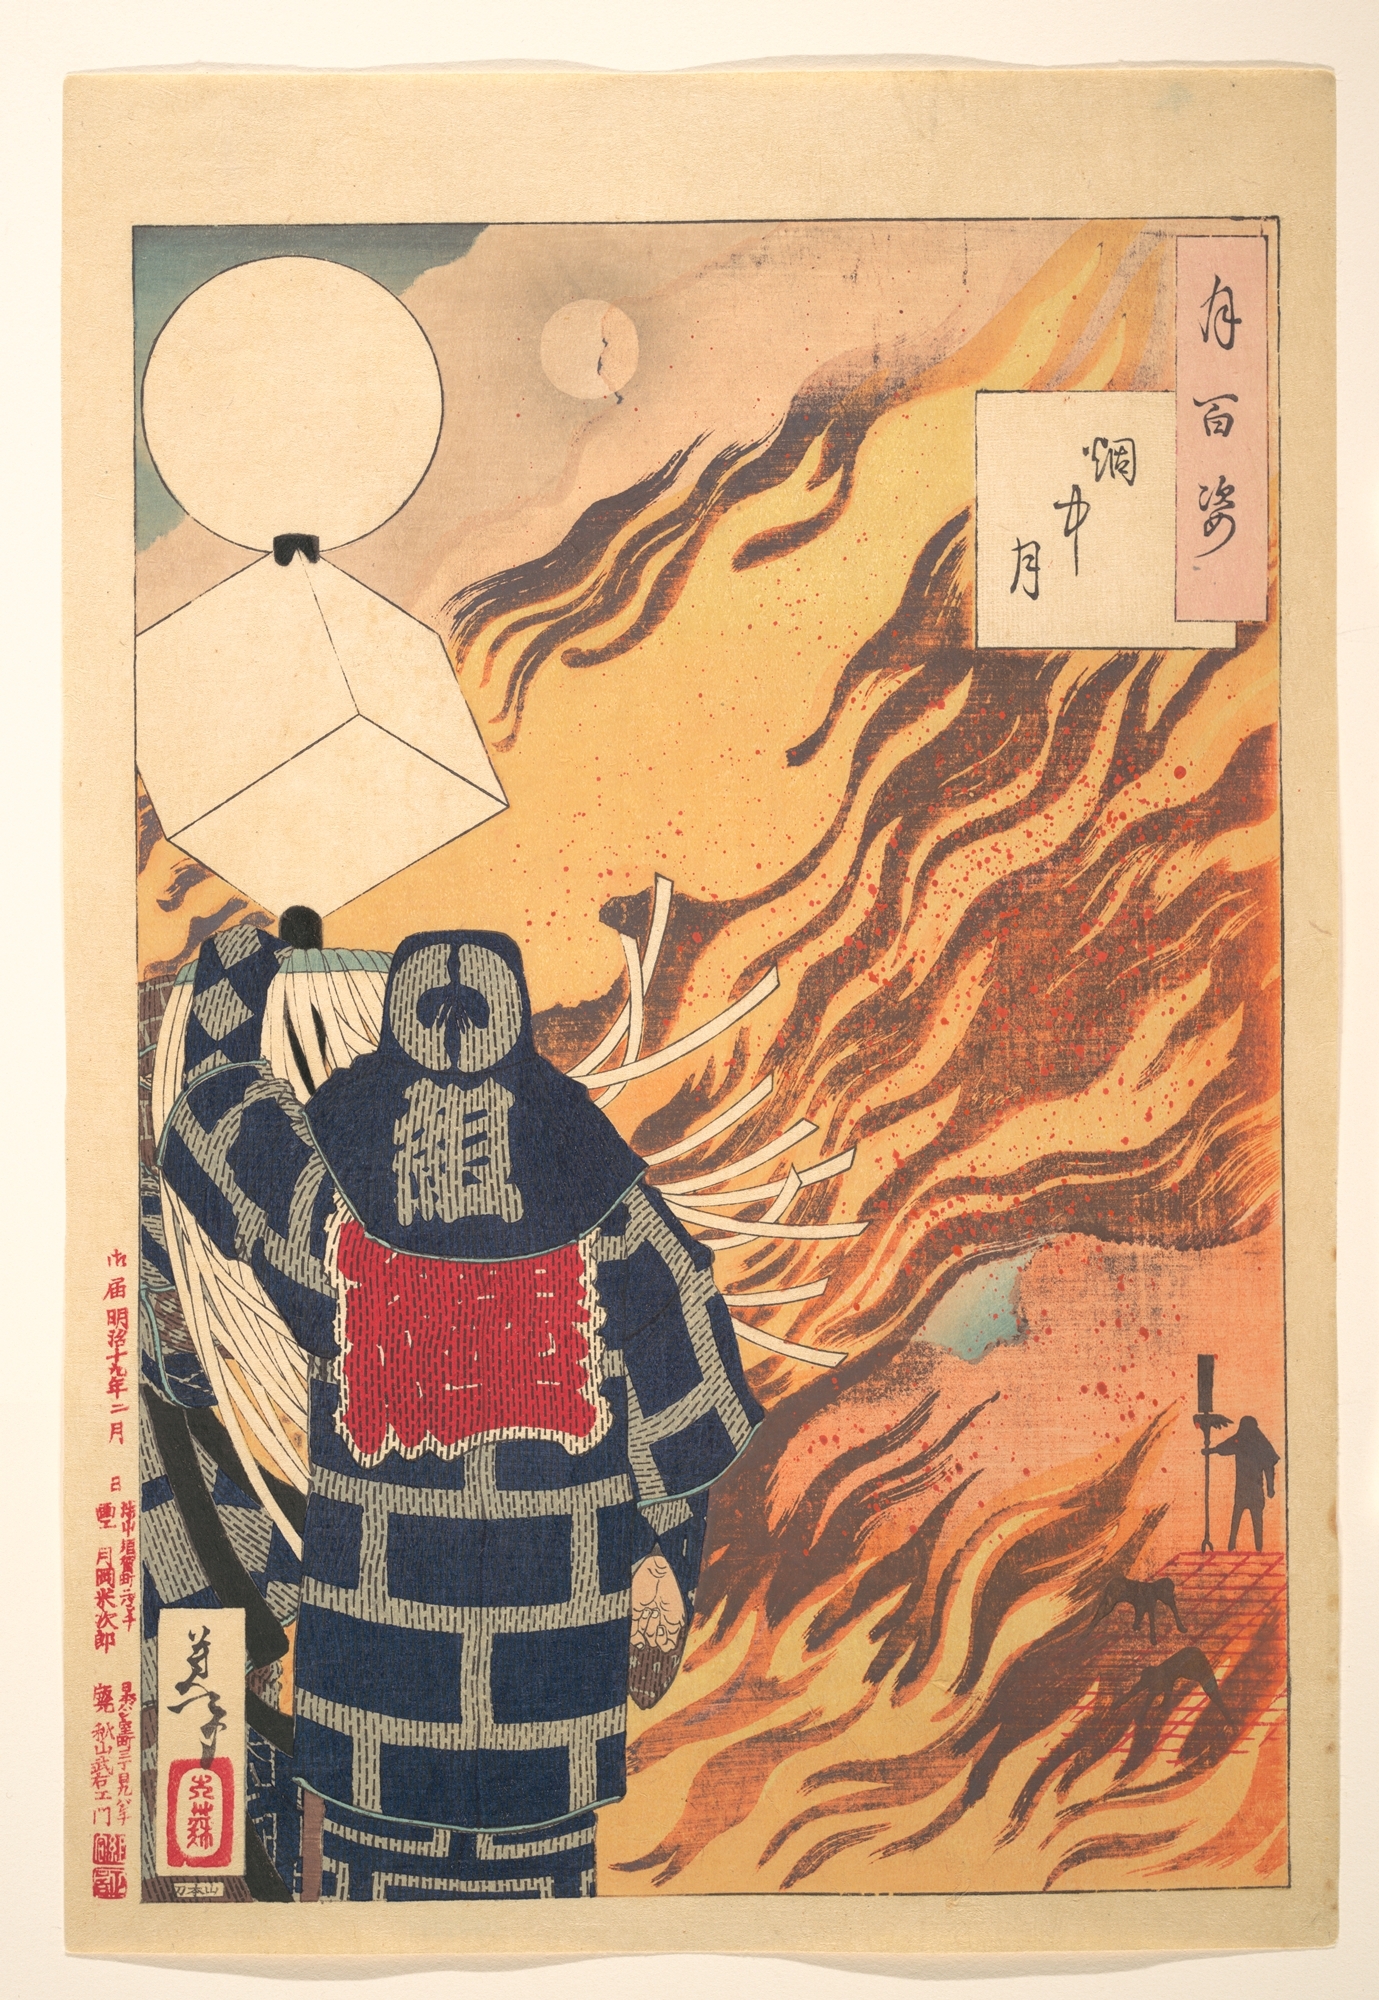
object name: print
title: Moon in the Flame from the Series One Hundred Images of the Moon (Tsuki hyaku sugata-enchūgetsu)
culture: japanese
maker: tsukioka yoshitoshi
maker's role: artist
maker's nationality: japanese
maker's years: 1839-1892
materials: ink, paper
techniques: woodblock print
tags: human figures,animals,moon,fires